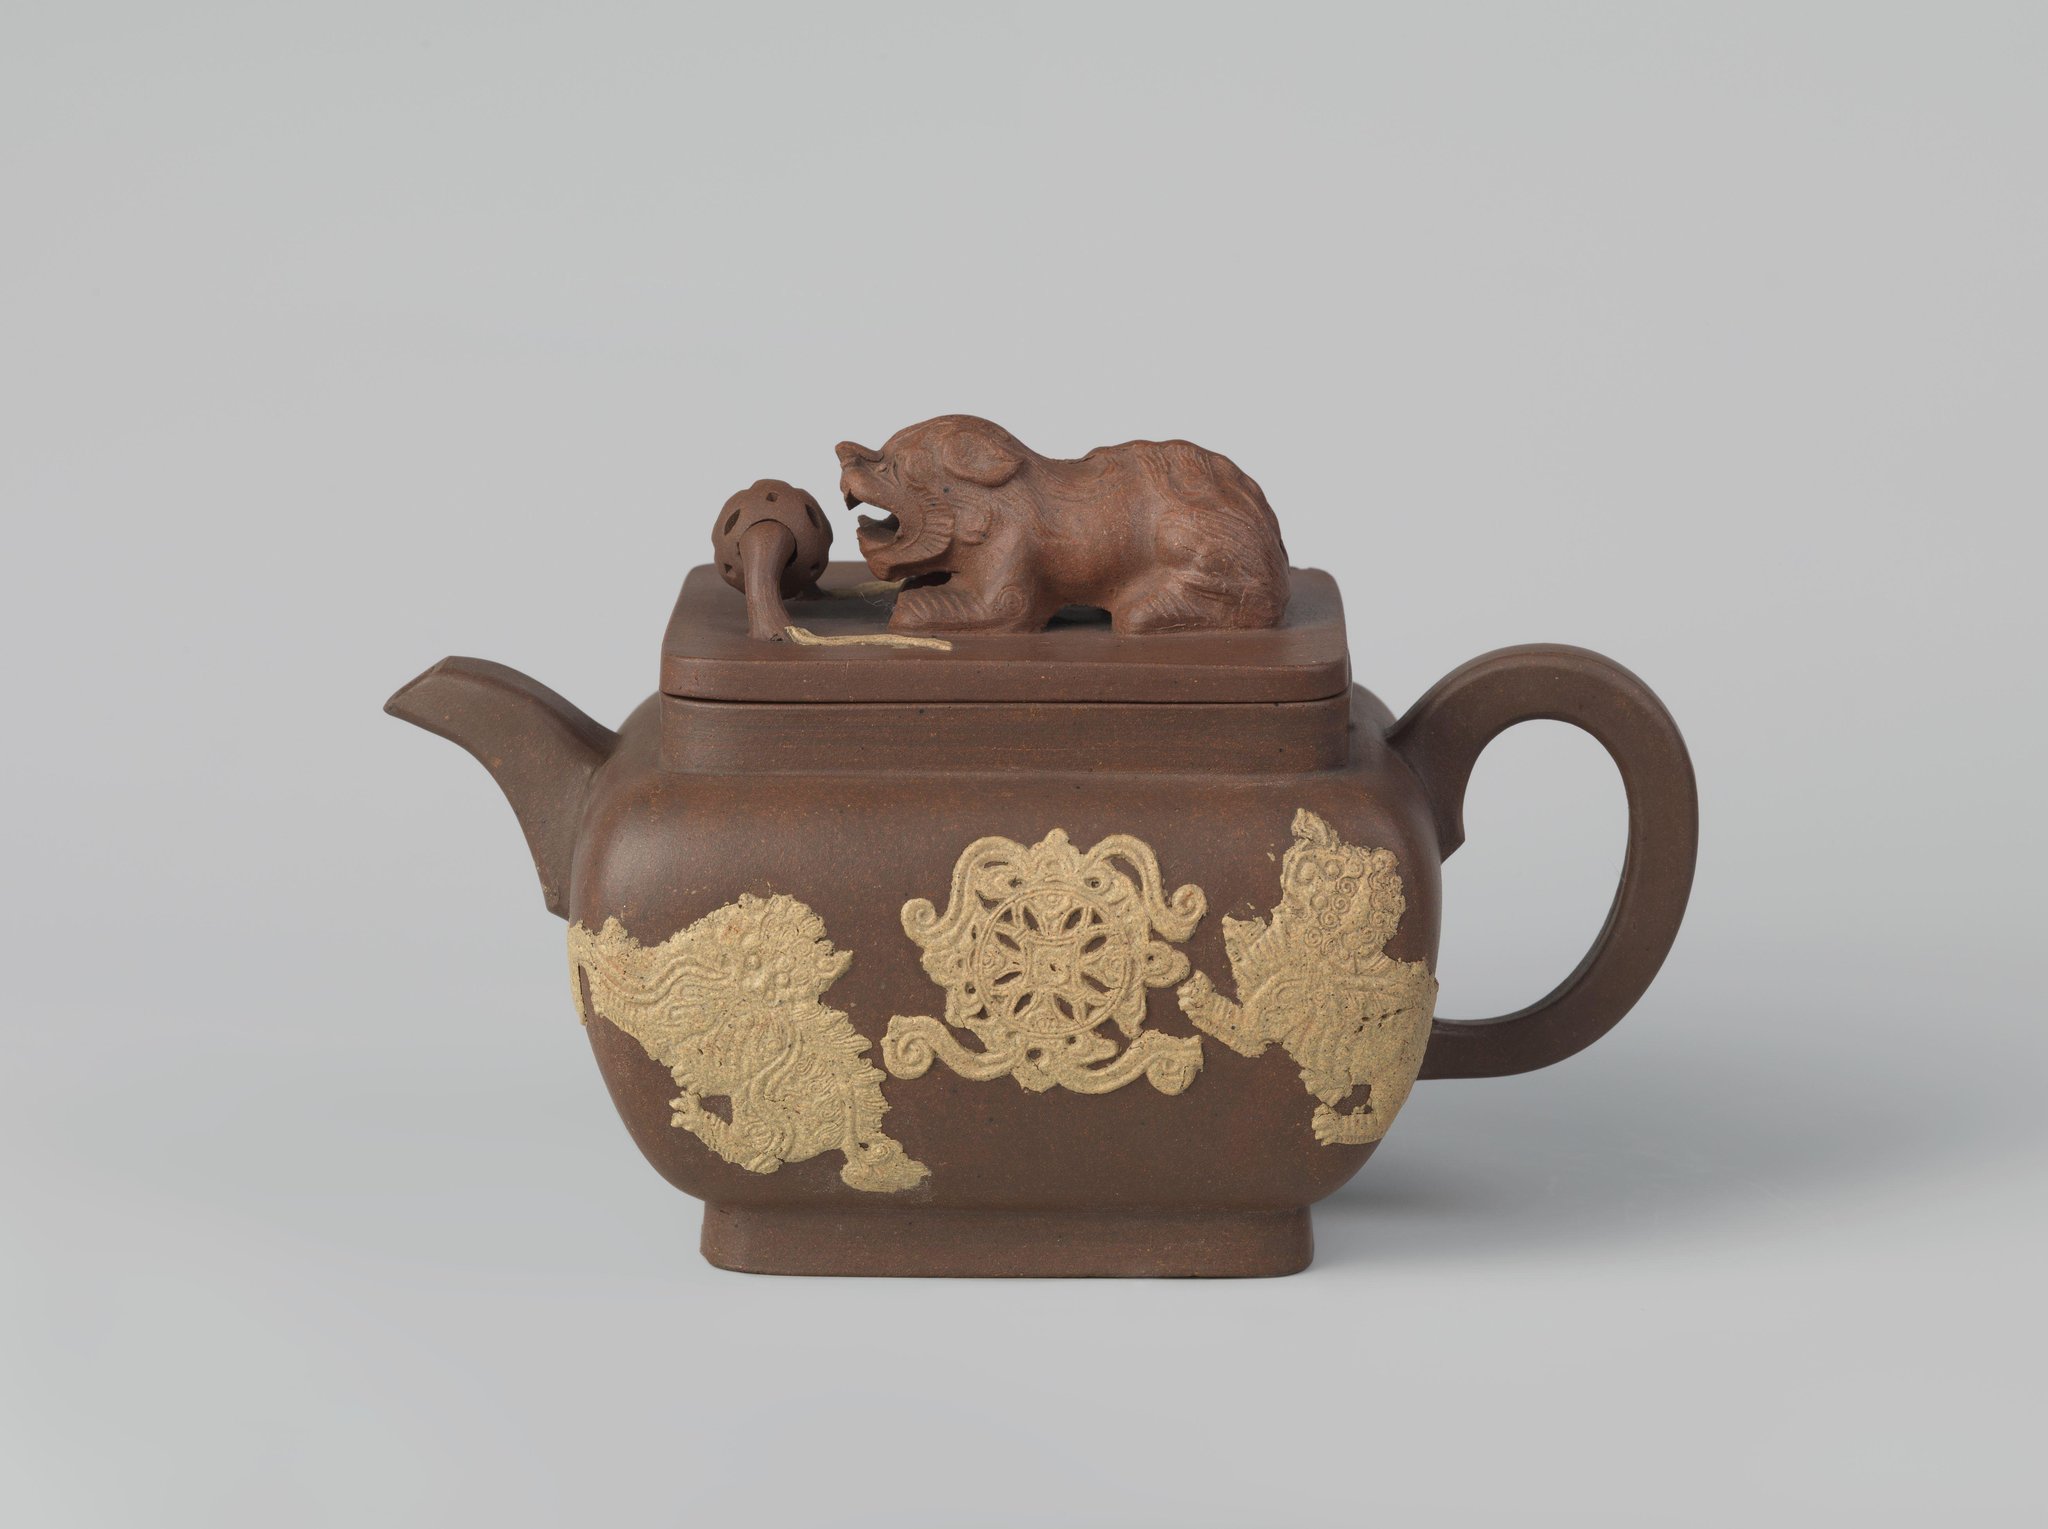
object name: lid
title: Teapot with a Decoration of Lions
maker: Anonymous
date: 1775-1799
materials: stoneware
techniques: firing, forming, relief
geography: china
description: The potter designed a special knop, or handle, for the lid: a reclining lion in front of a spinning ball. The same motif is mirrored on the teapot’s body, where two lions play with an openwork ball. In Chinese culture, lions (shizi), carry positive connotations as they are believed to ward off malevolent spirits and usher in good fortune.